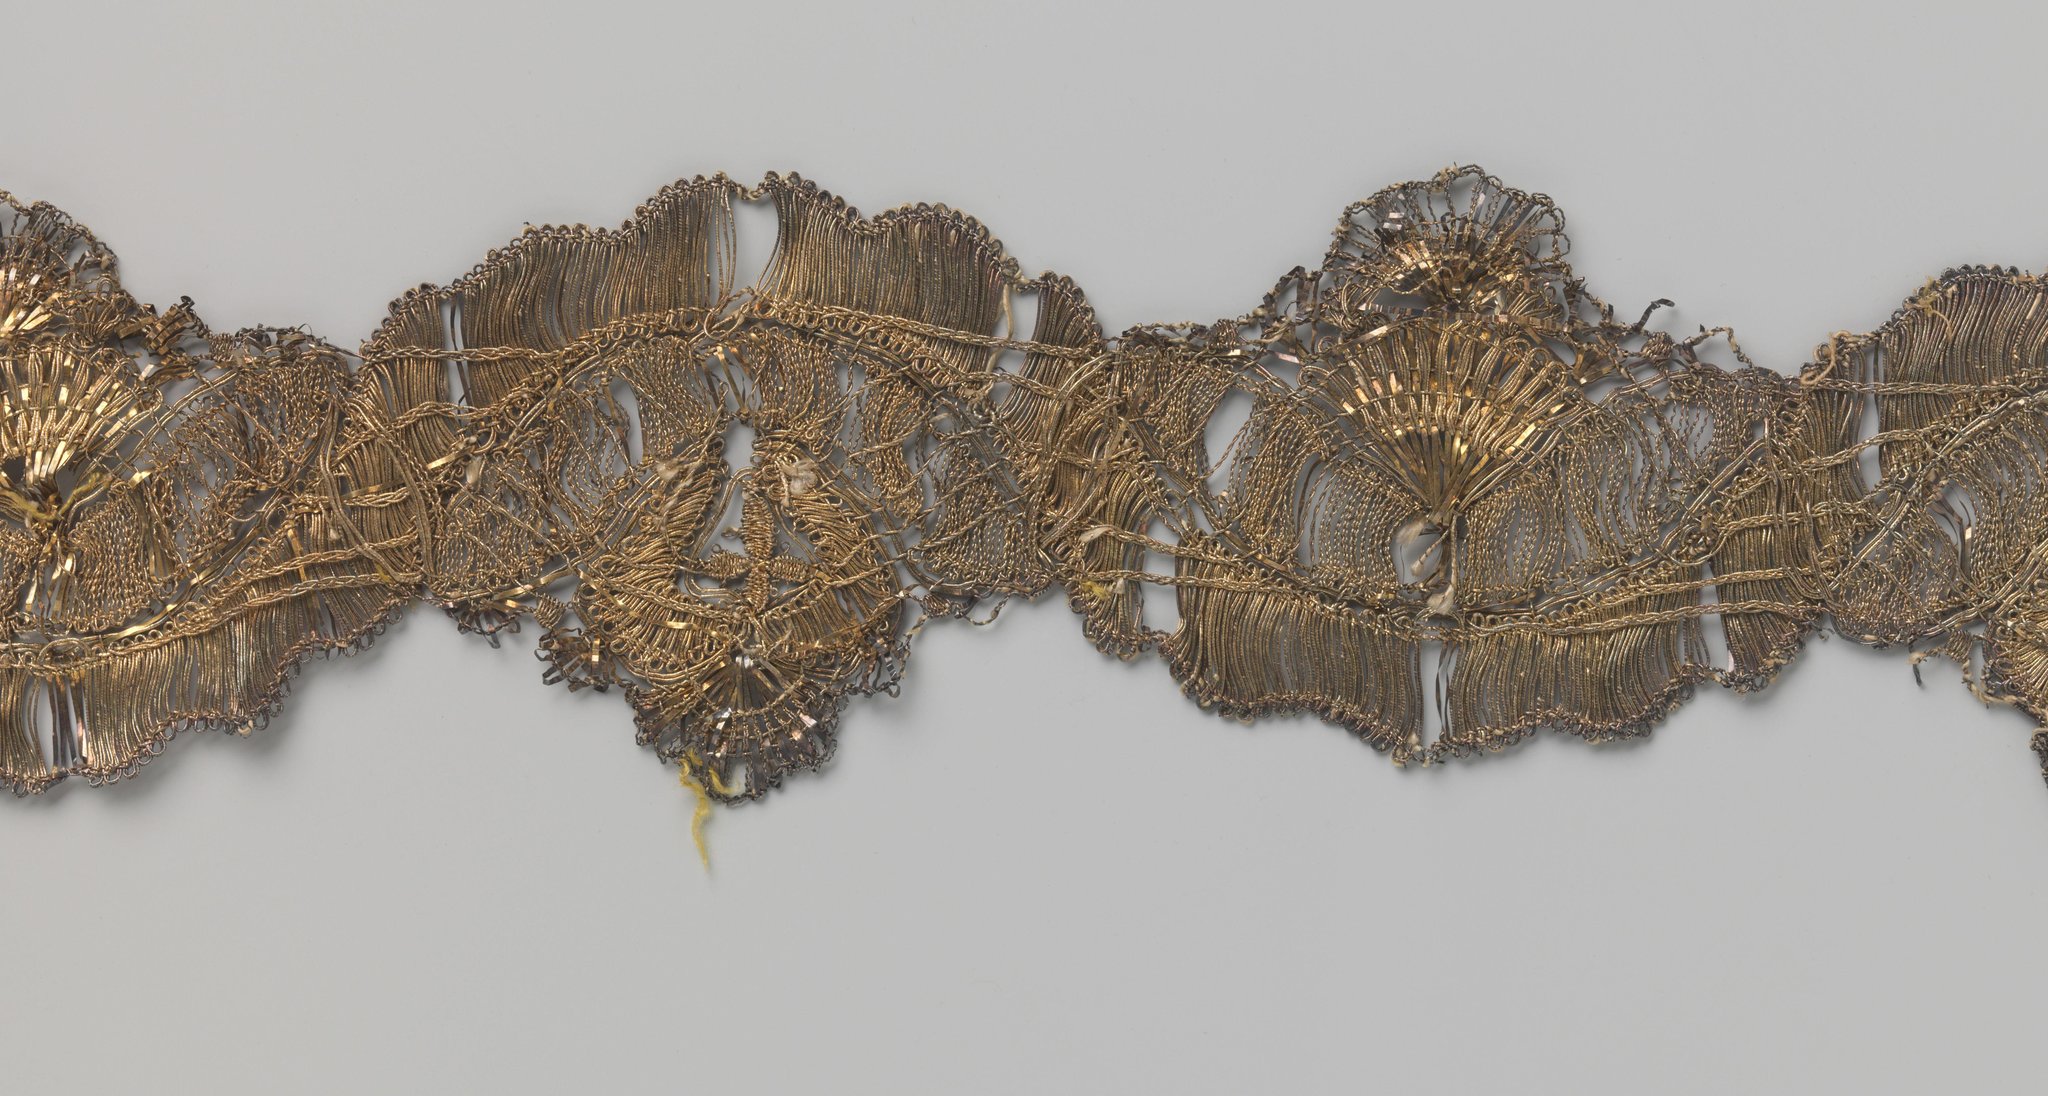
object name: strip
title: Strook goudkant met brede golvende band en waaiervormen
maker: Anonymous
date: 1700-1799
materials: gold thread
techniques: lace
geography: france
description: Strook kloskant, goudkant. Het patroon bestaat uit schulpen met waaiervormen, die ontstaan onder en boven een brede golvende band van verticaal gespannen draden. De schulpen bestaan afwisselend uit een waaier bekroond door een kleinere waaier en een hart bekroond door een waaier. In het hart staat een kruisje gemaakt in vormslag. Er is gewerkt met lamelgouddraad, gladde filégaren en geribbelde filégaren, in verschillende diktes.